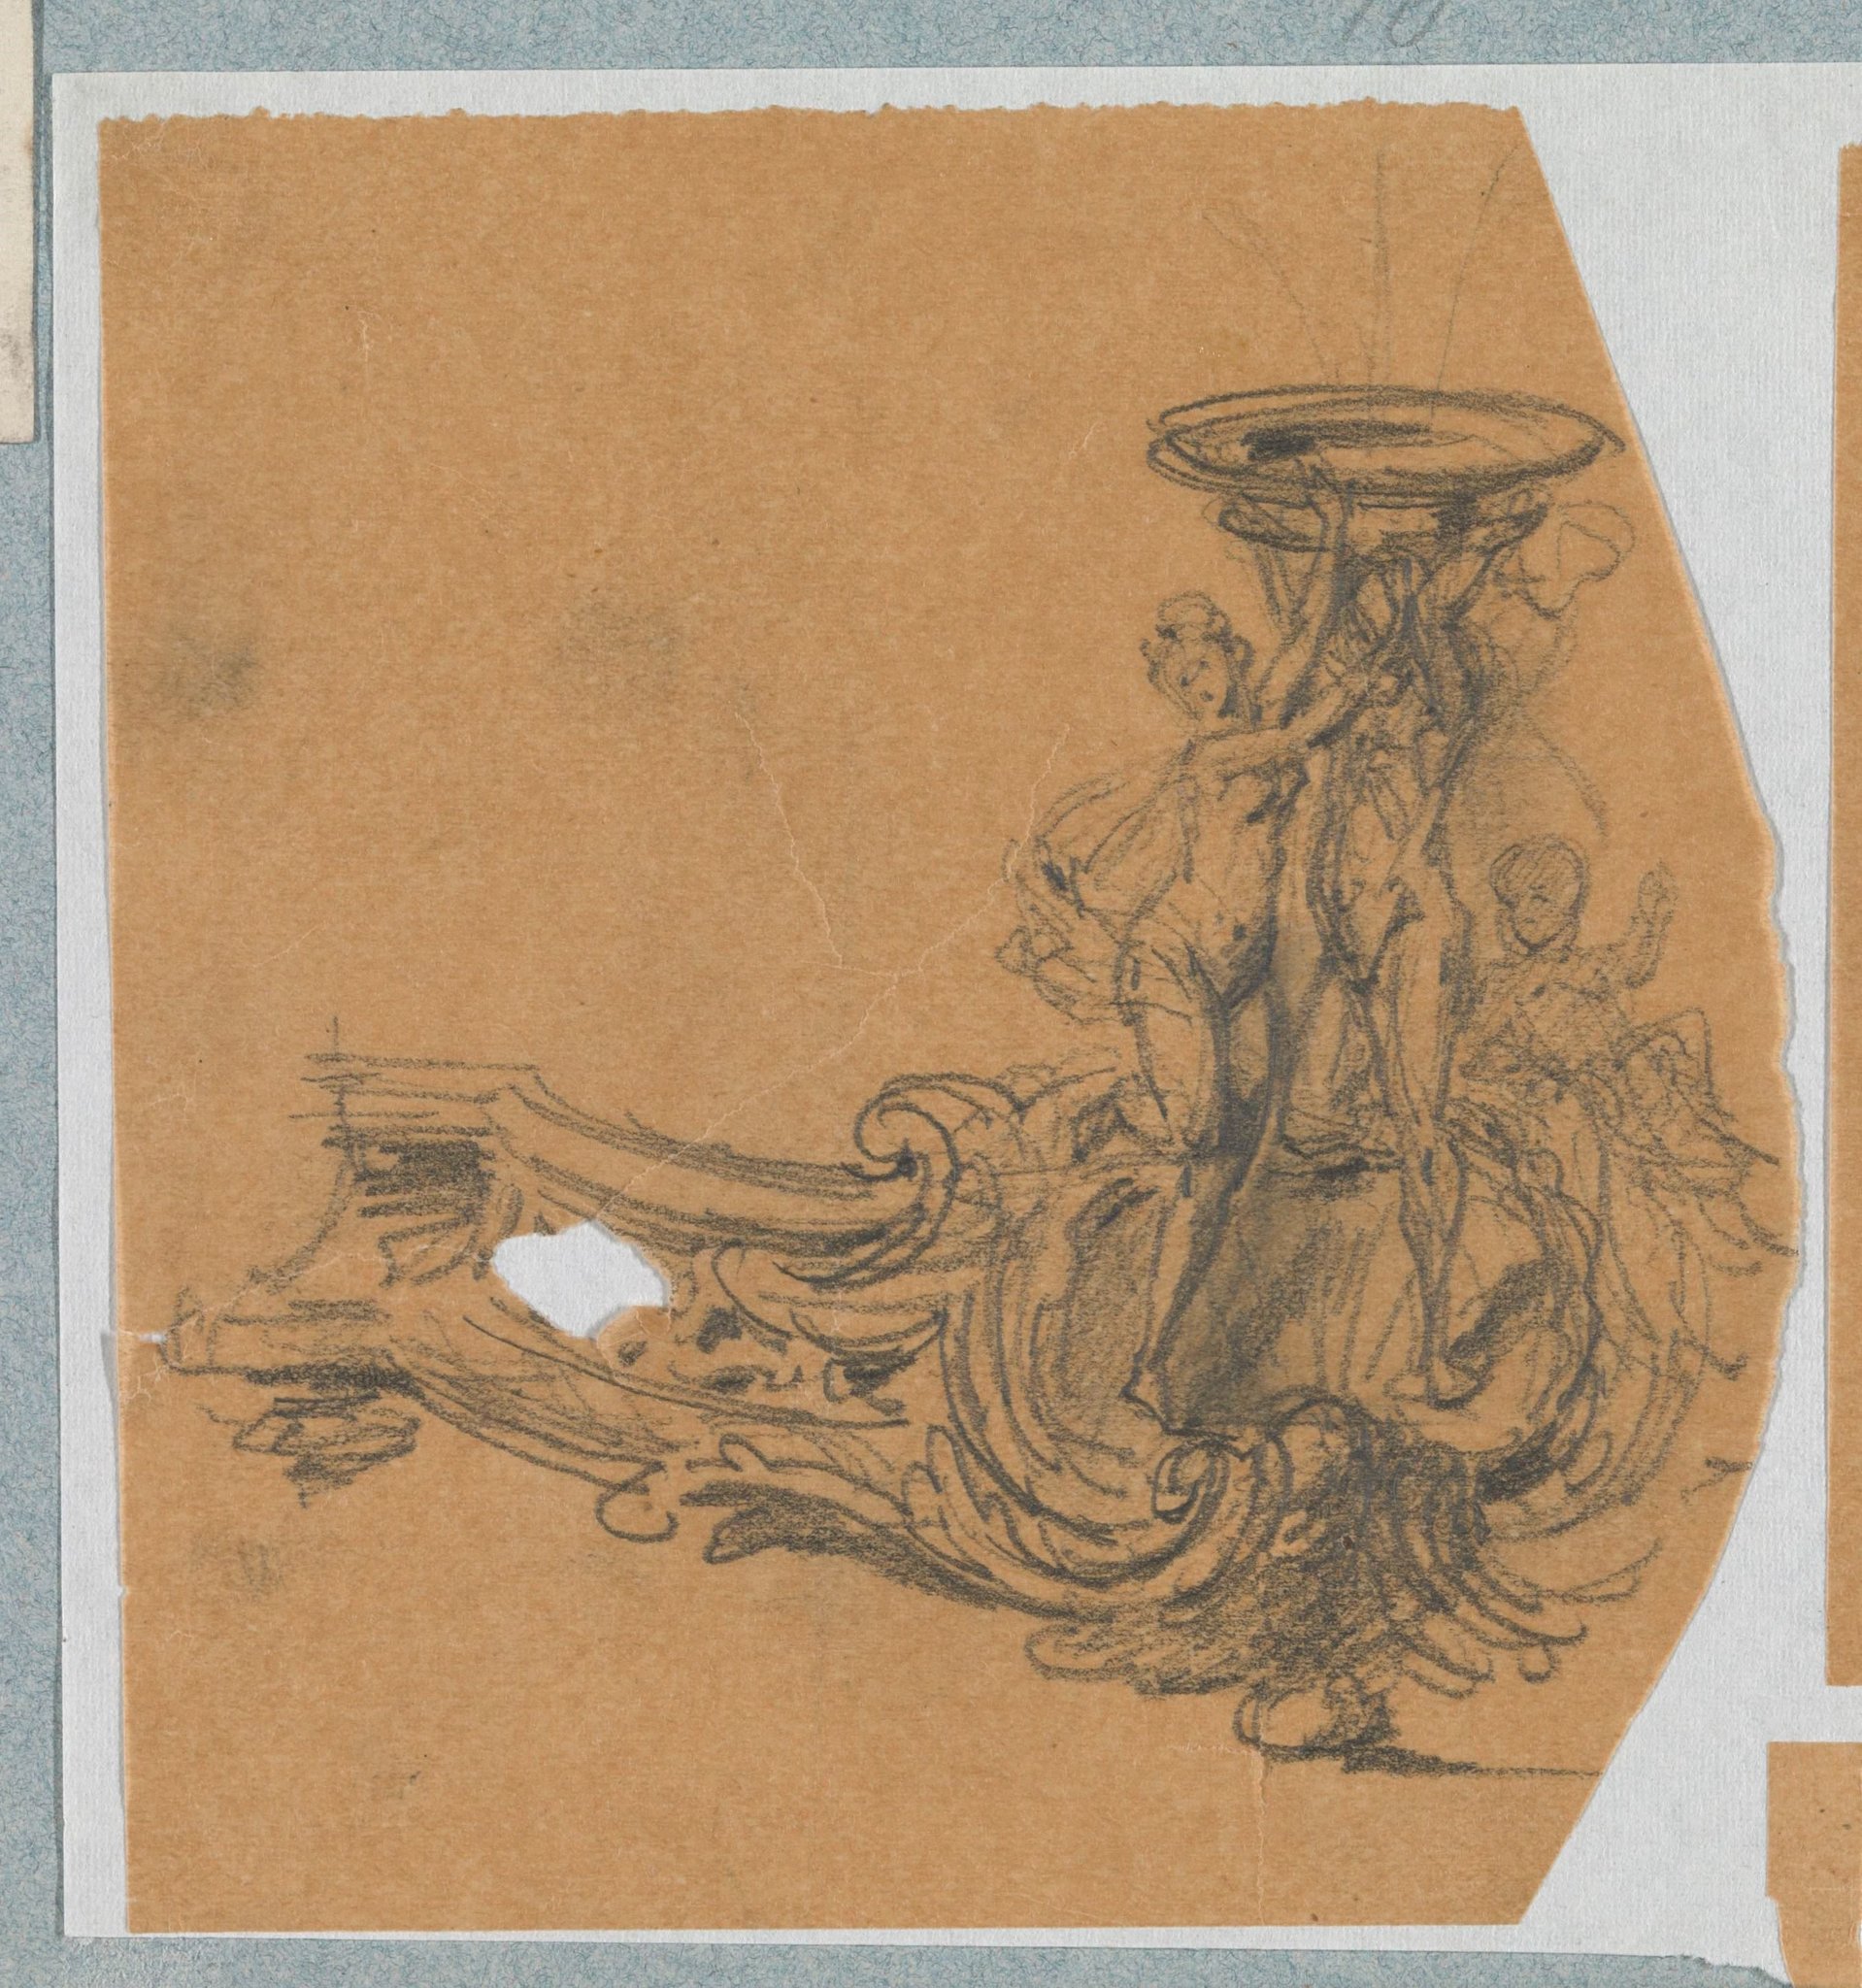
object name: design drawing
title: Ontwerp voor de linkerhelft van een tafelstuk met figuren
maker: henri cameré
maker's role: designer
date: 1864-1894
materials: pencil, paper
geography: paris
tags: centre-piece, epergne, 'surtout', 'milieu-de-table'